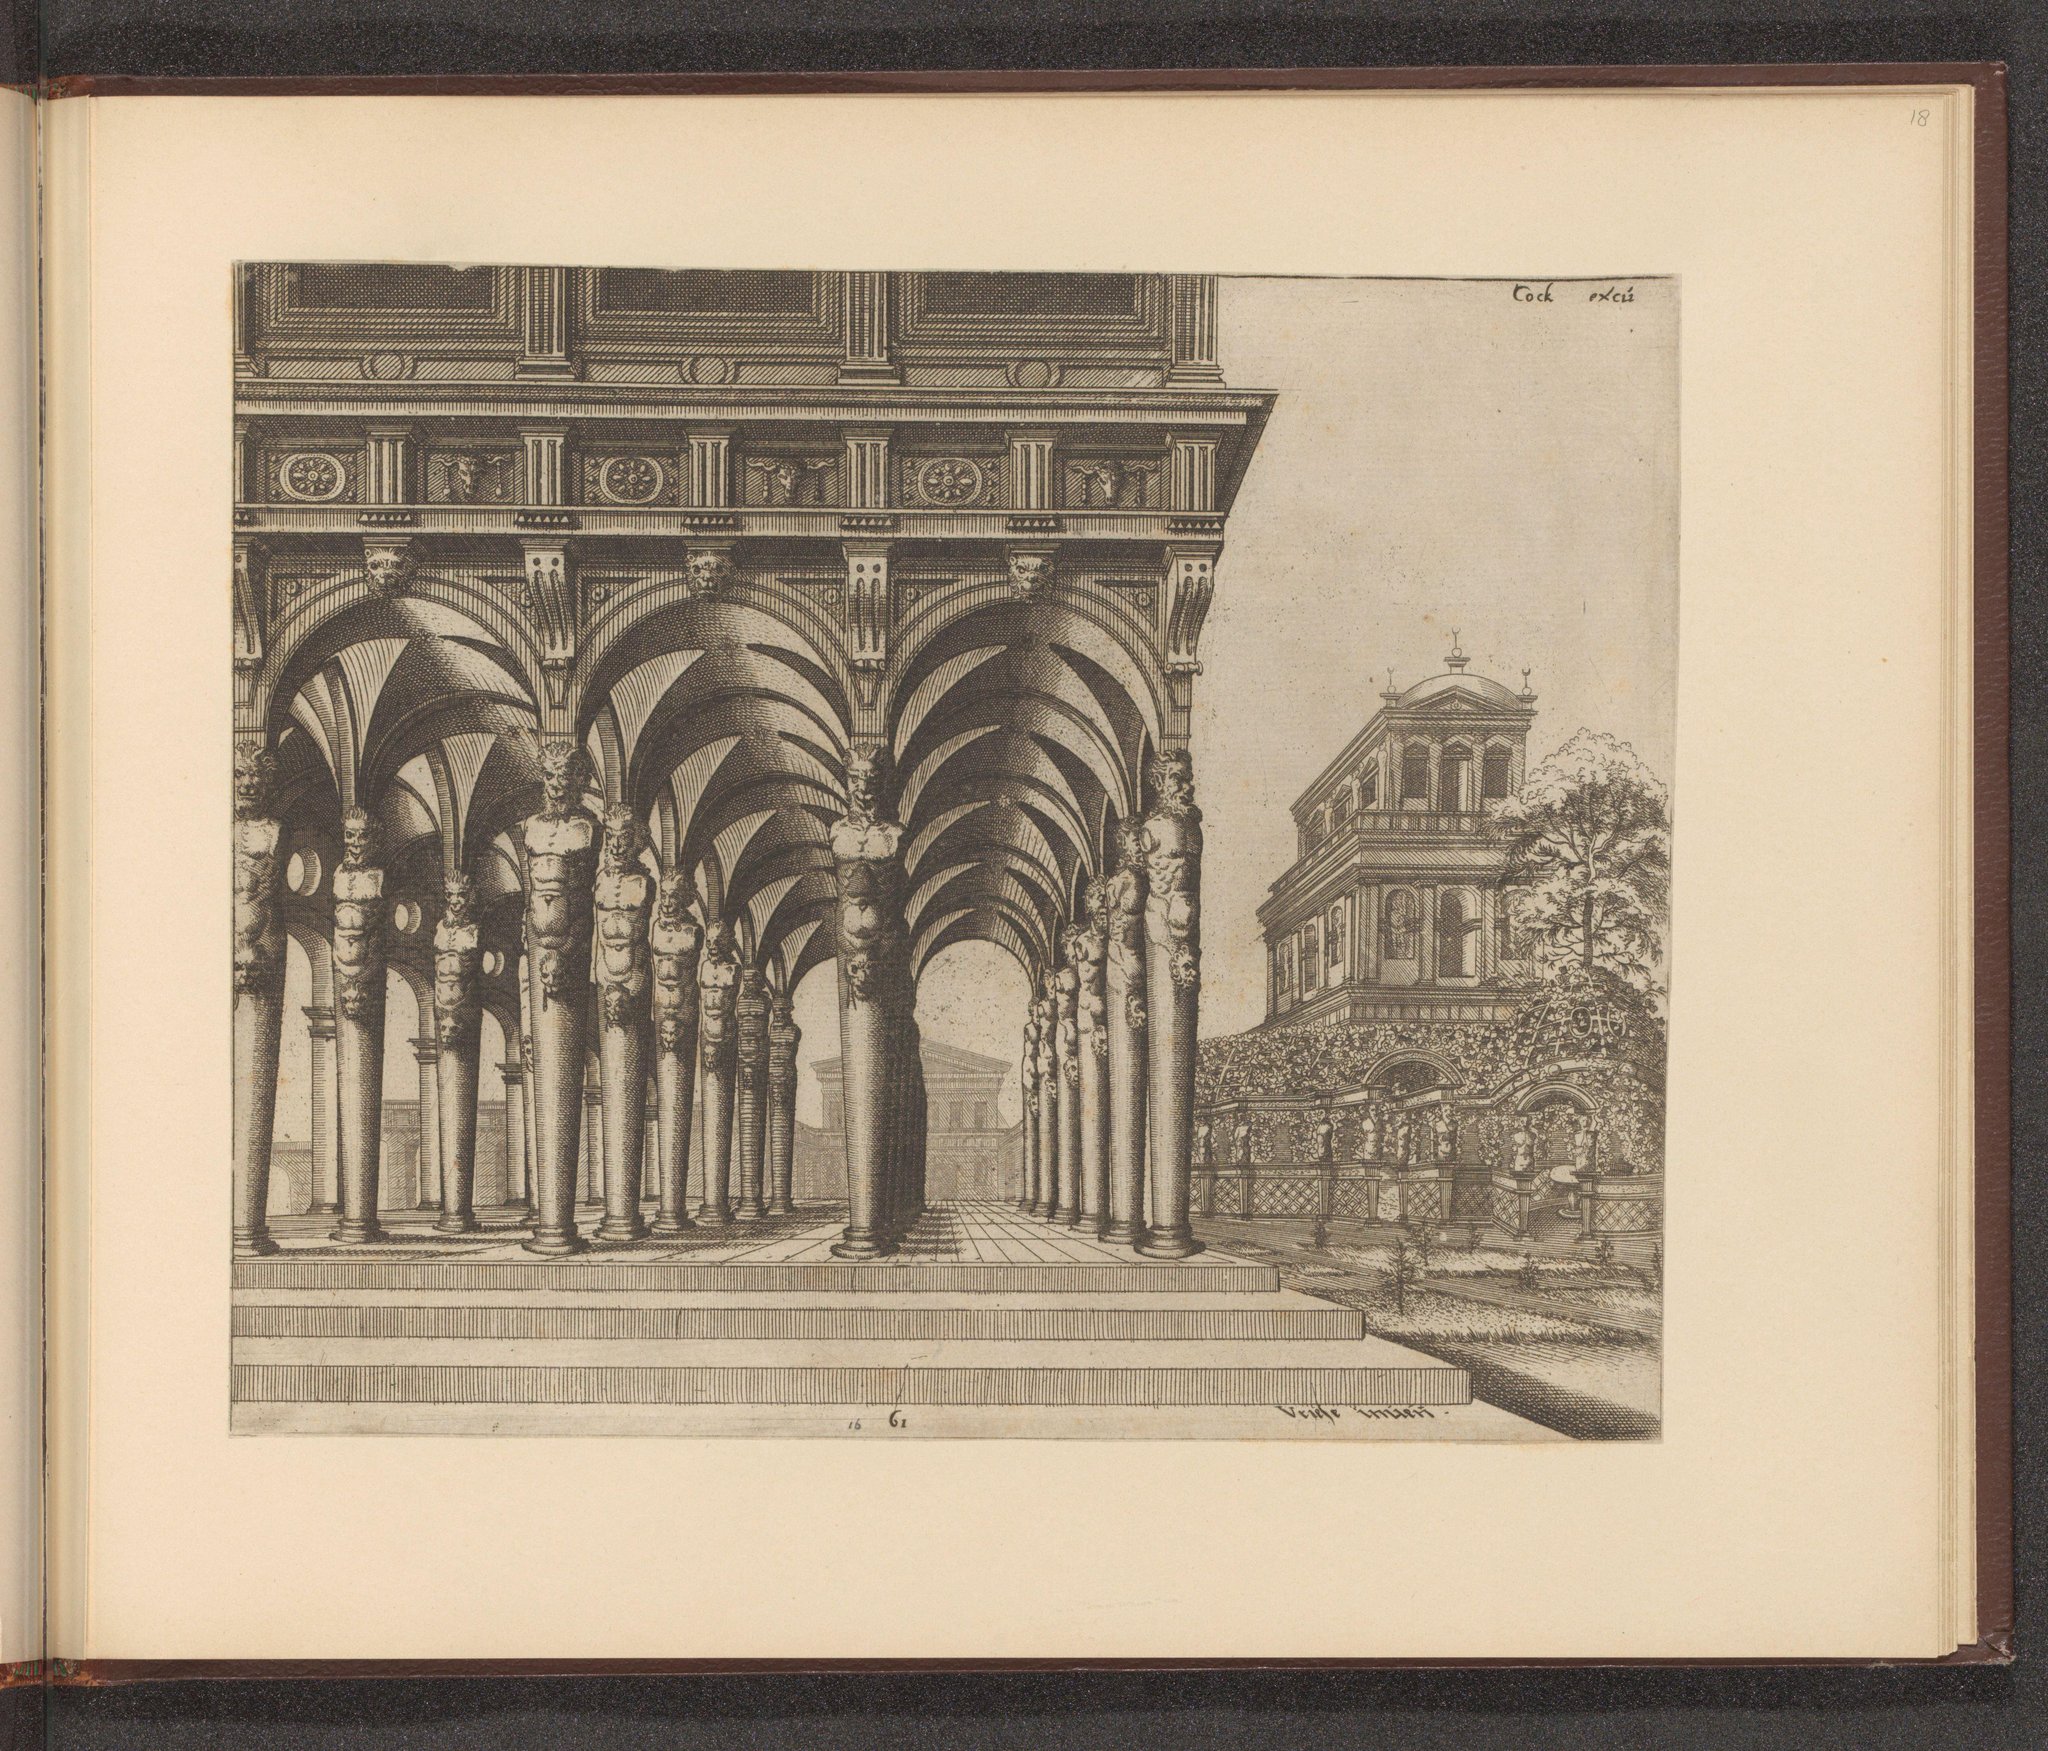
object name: print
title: Loggia gedragen door saterhermen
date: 1563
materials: paper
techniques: etching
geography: antwerp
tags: other hybrid forms in the shape of a pillar, loggia, verandah, porch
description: Loggia gedragen door hermen in de vorm van saters. Rechts een tuin met een berceau voor een paleis. Prent maakt deel uit van een album.